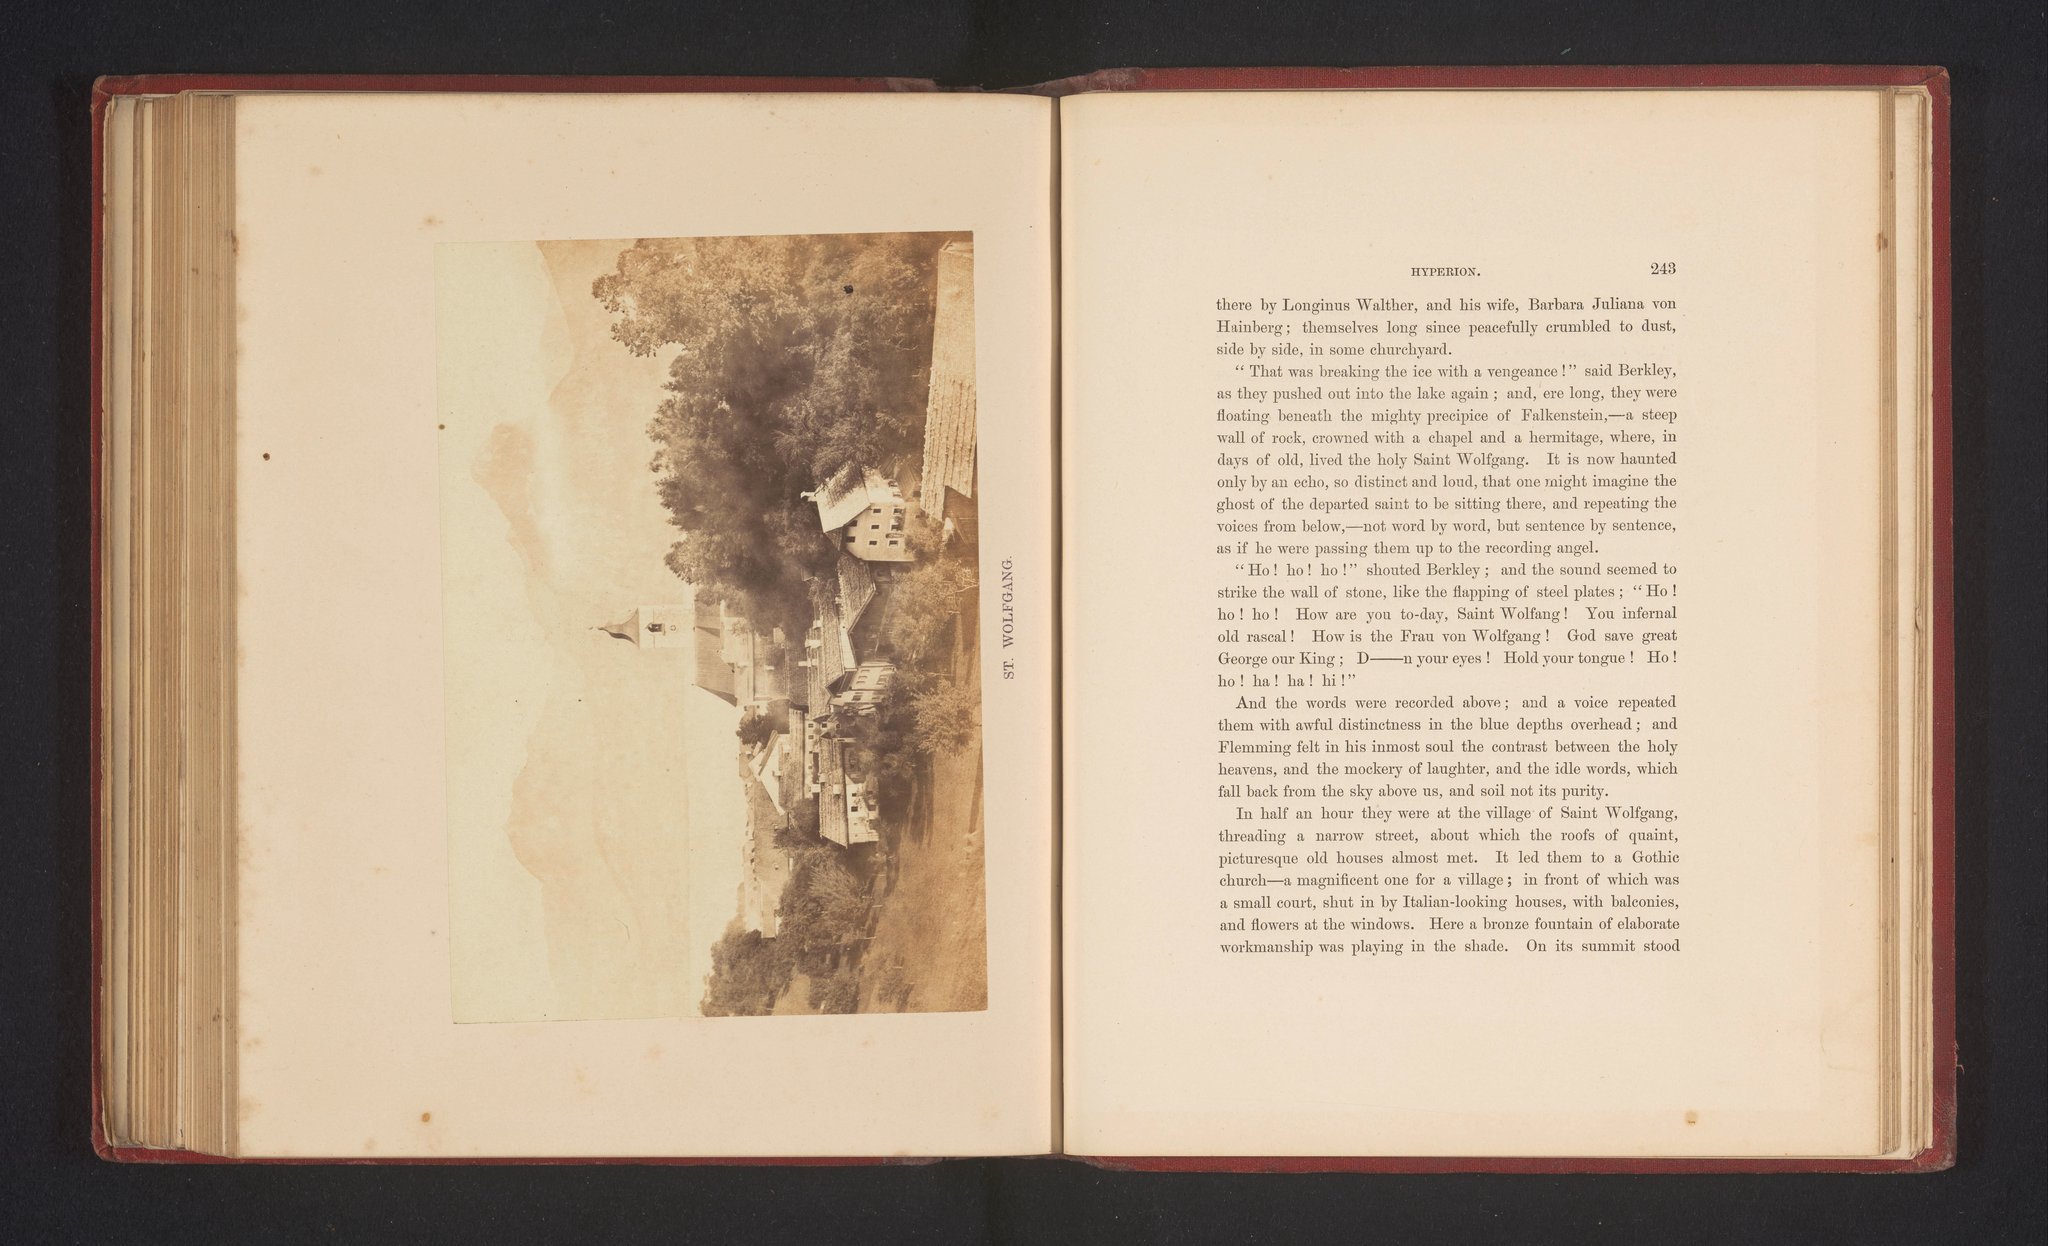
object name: page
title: St. Wolfgang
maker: francis frith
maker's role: publisher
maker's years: 1822-1898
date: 1855-1865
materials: photographic support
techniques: albumen print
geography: sankt wolfgang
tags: city-view, and landscape with man-made constructions, parts of church exterior and annexes: tower, mountains